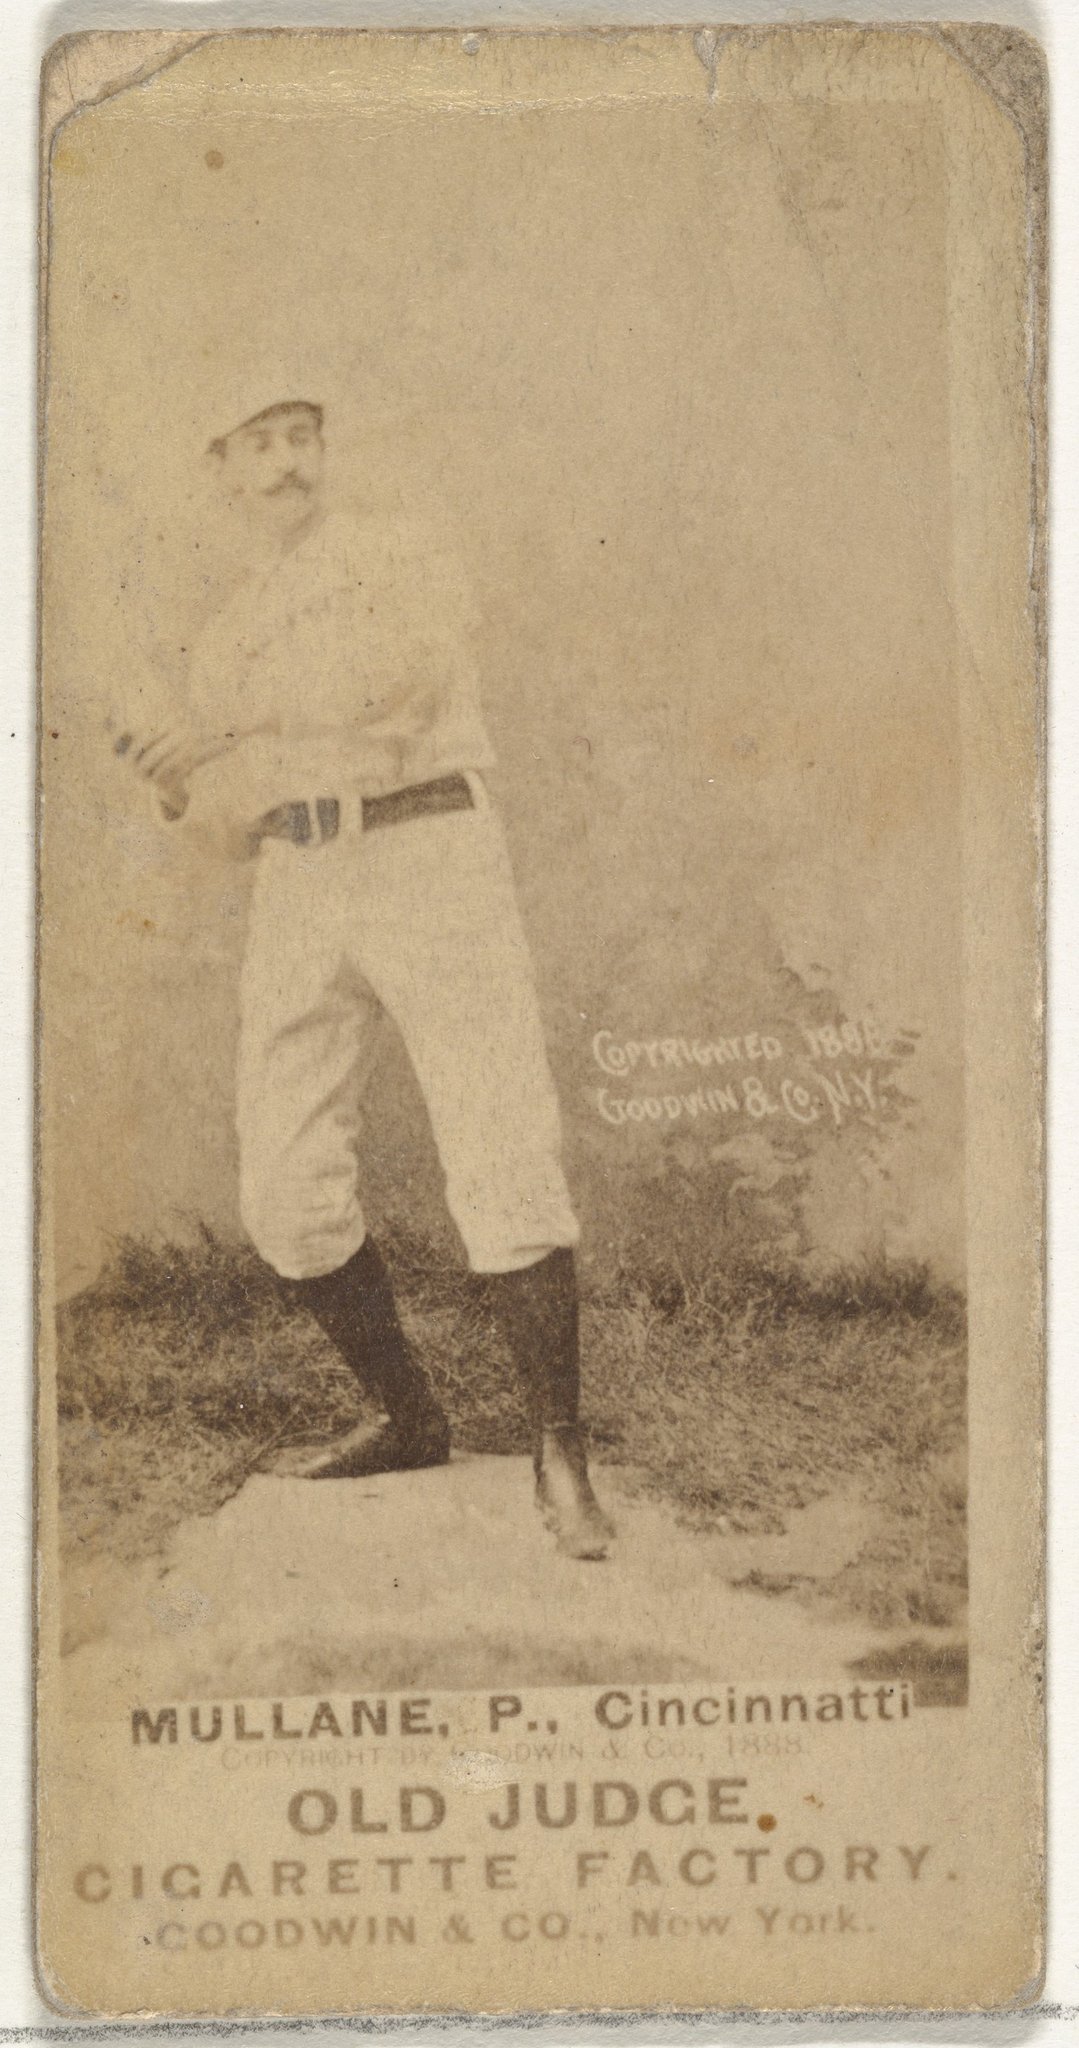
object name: baseball card, photograph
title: Anthony John "Tony" Mullane, Pitcher, Cincinnati, from the Old Judge series (N172) for Old Judge Cigarettes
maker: goodwin & company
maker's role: publisher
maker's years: 1850-1950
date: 1888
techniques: albumen silver print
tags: men,baseball,athletes